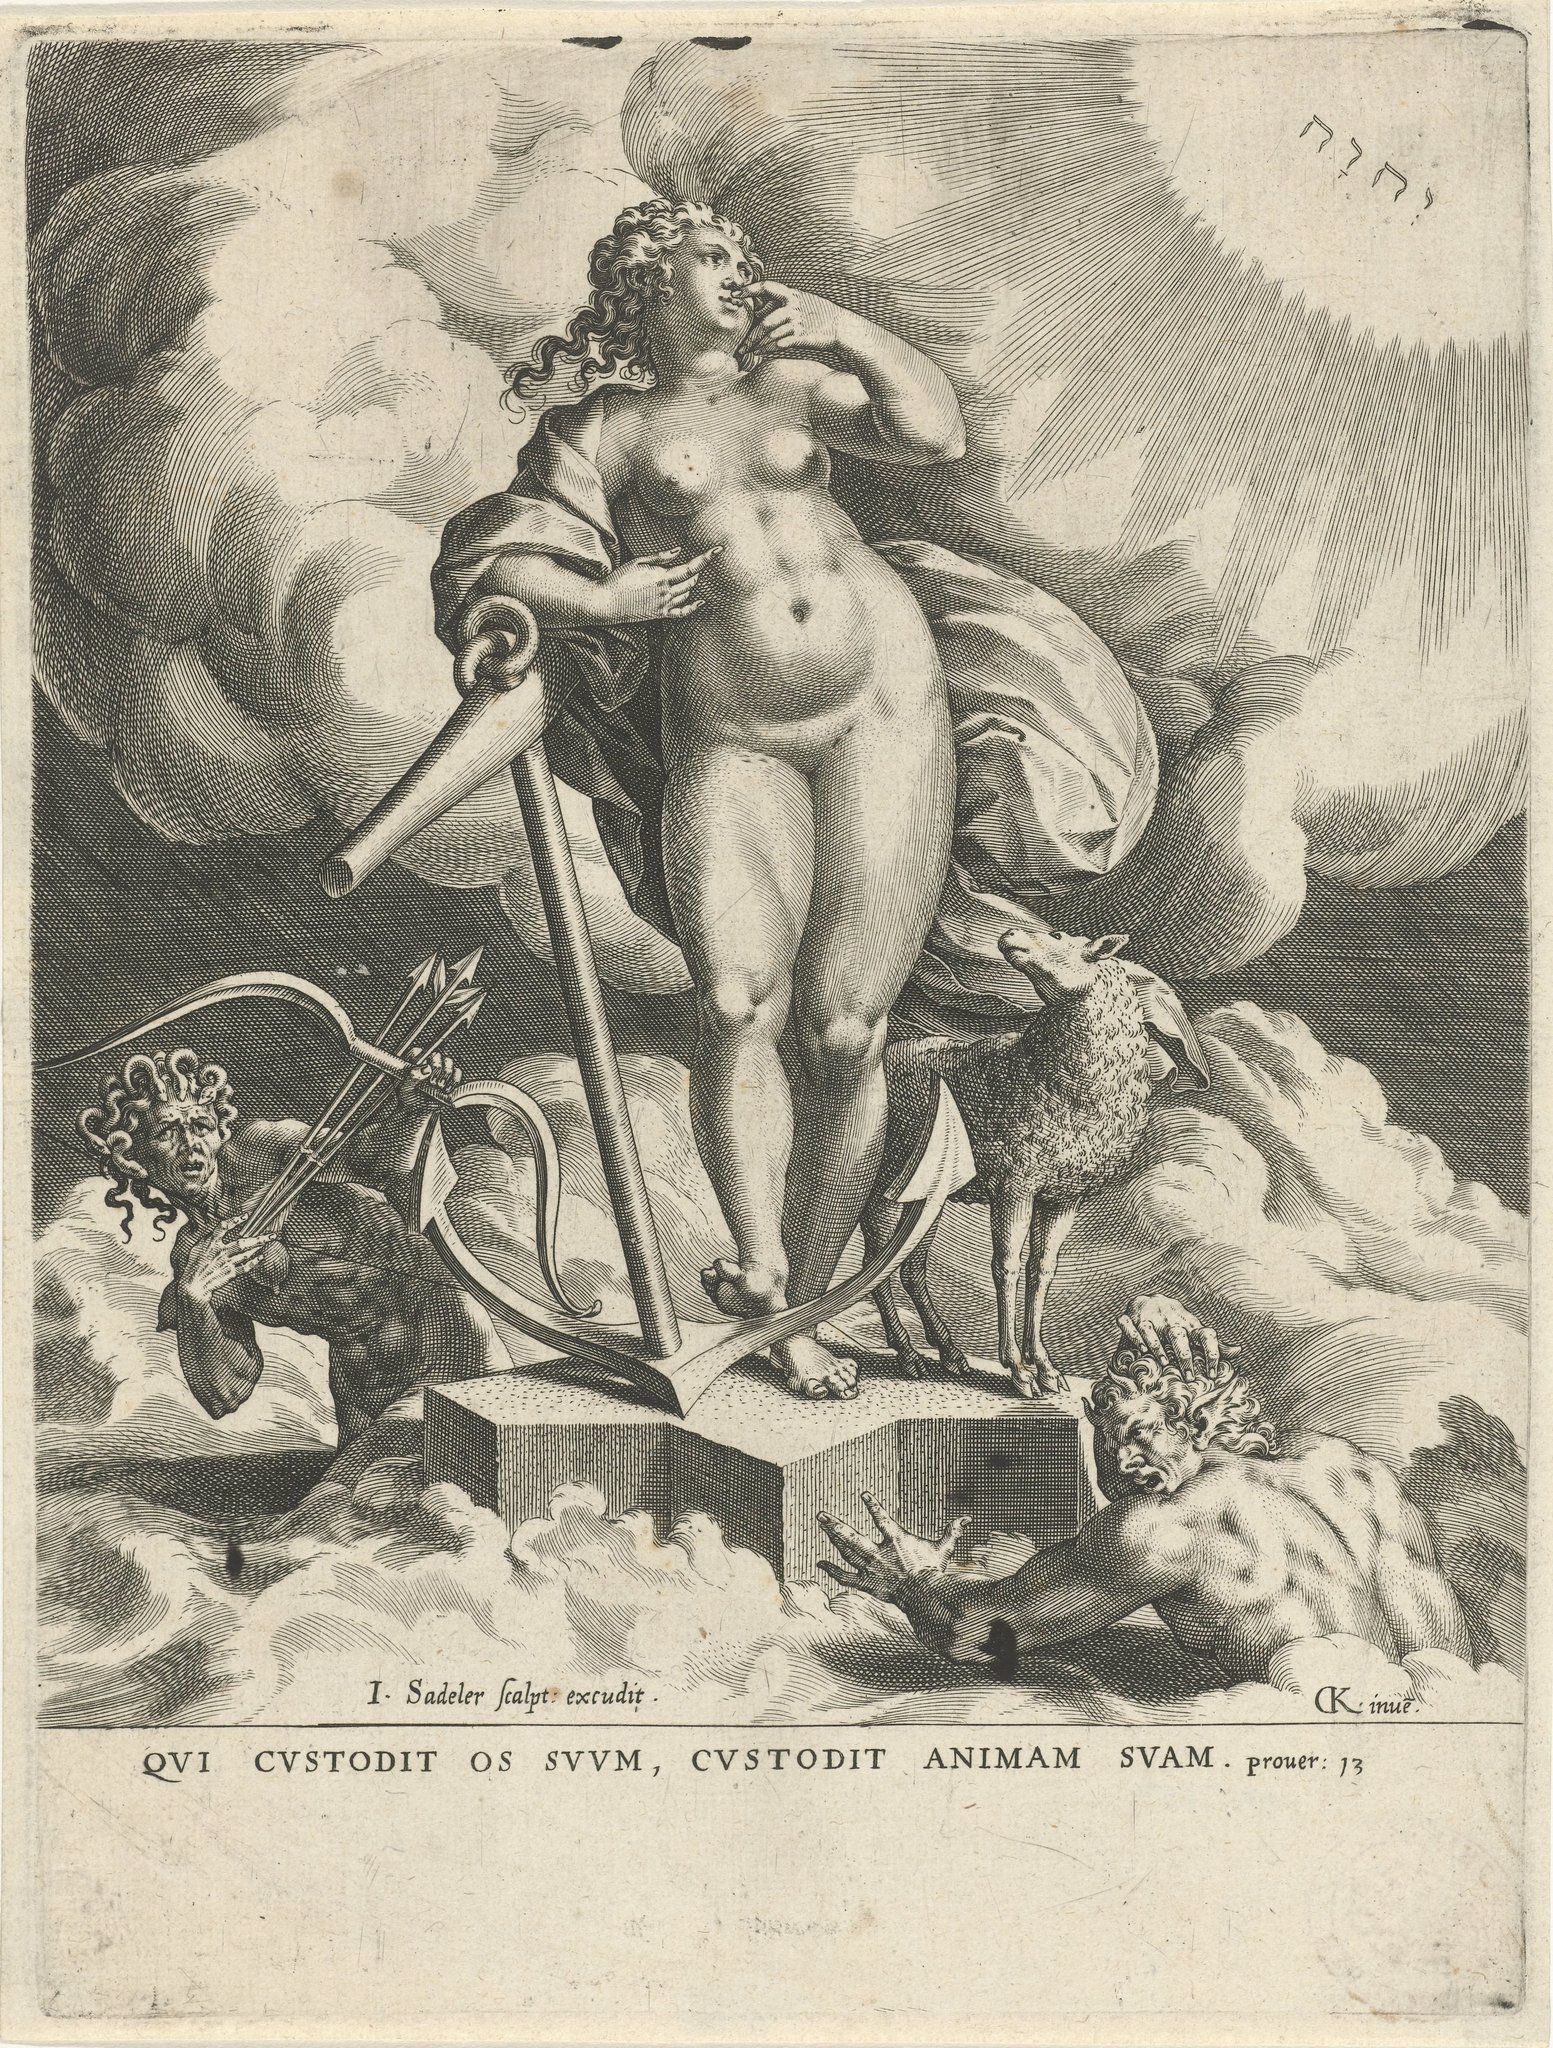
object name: print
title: Allegorie van de Hoop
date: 1560-1600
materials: paper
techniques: engraving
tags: envy; 'invidia' (ripa) ~ personification of one of the seven deadly sins, hope; 'speranza', 'speranza delle fatiche' (ripa), tetragram (in roman or hebrew script) ~ symbol of god the father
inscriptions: collector's mark: Lugt 240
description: Personificatie van de Hoop: een standbeeld van vrouw met een anker op een sokkel in de wolken. Naast haar een lam. Hoop kijkt naar de hemel (rechts) waar het tetragram in de lucht is verschenen, omgeven door lichtstralen. Afgunst (Invidia) schiet met een boog pijlen op haar af.